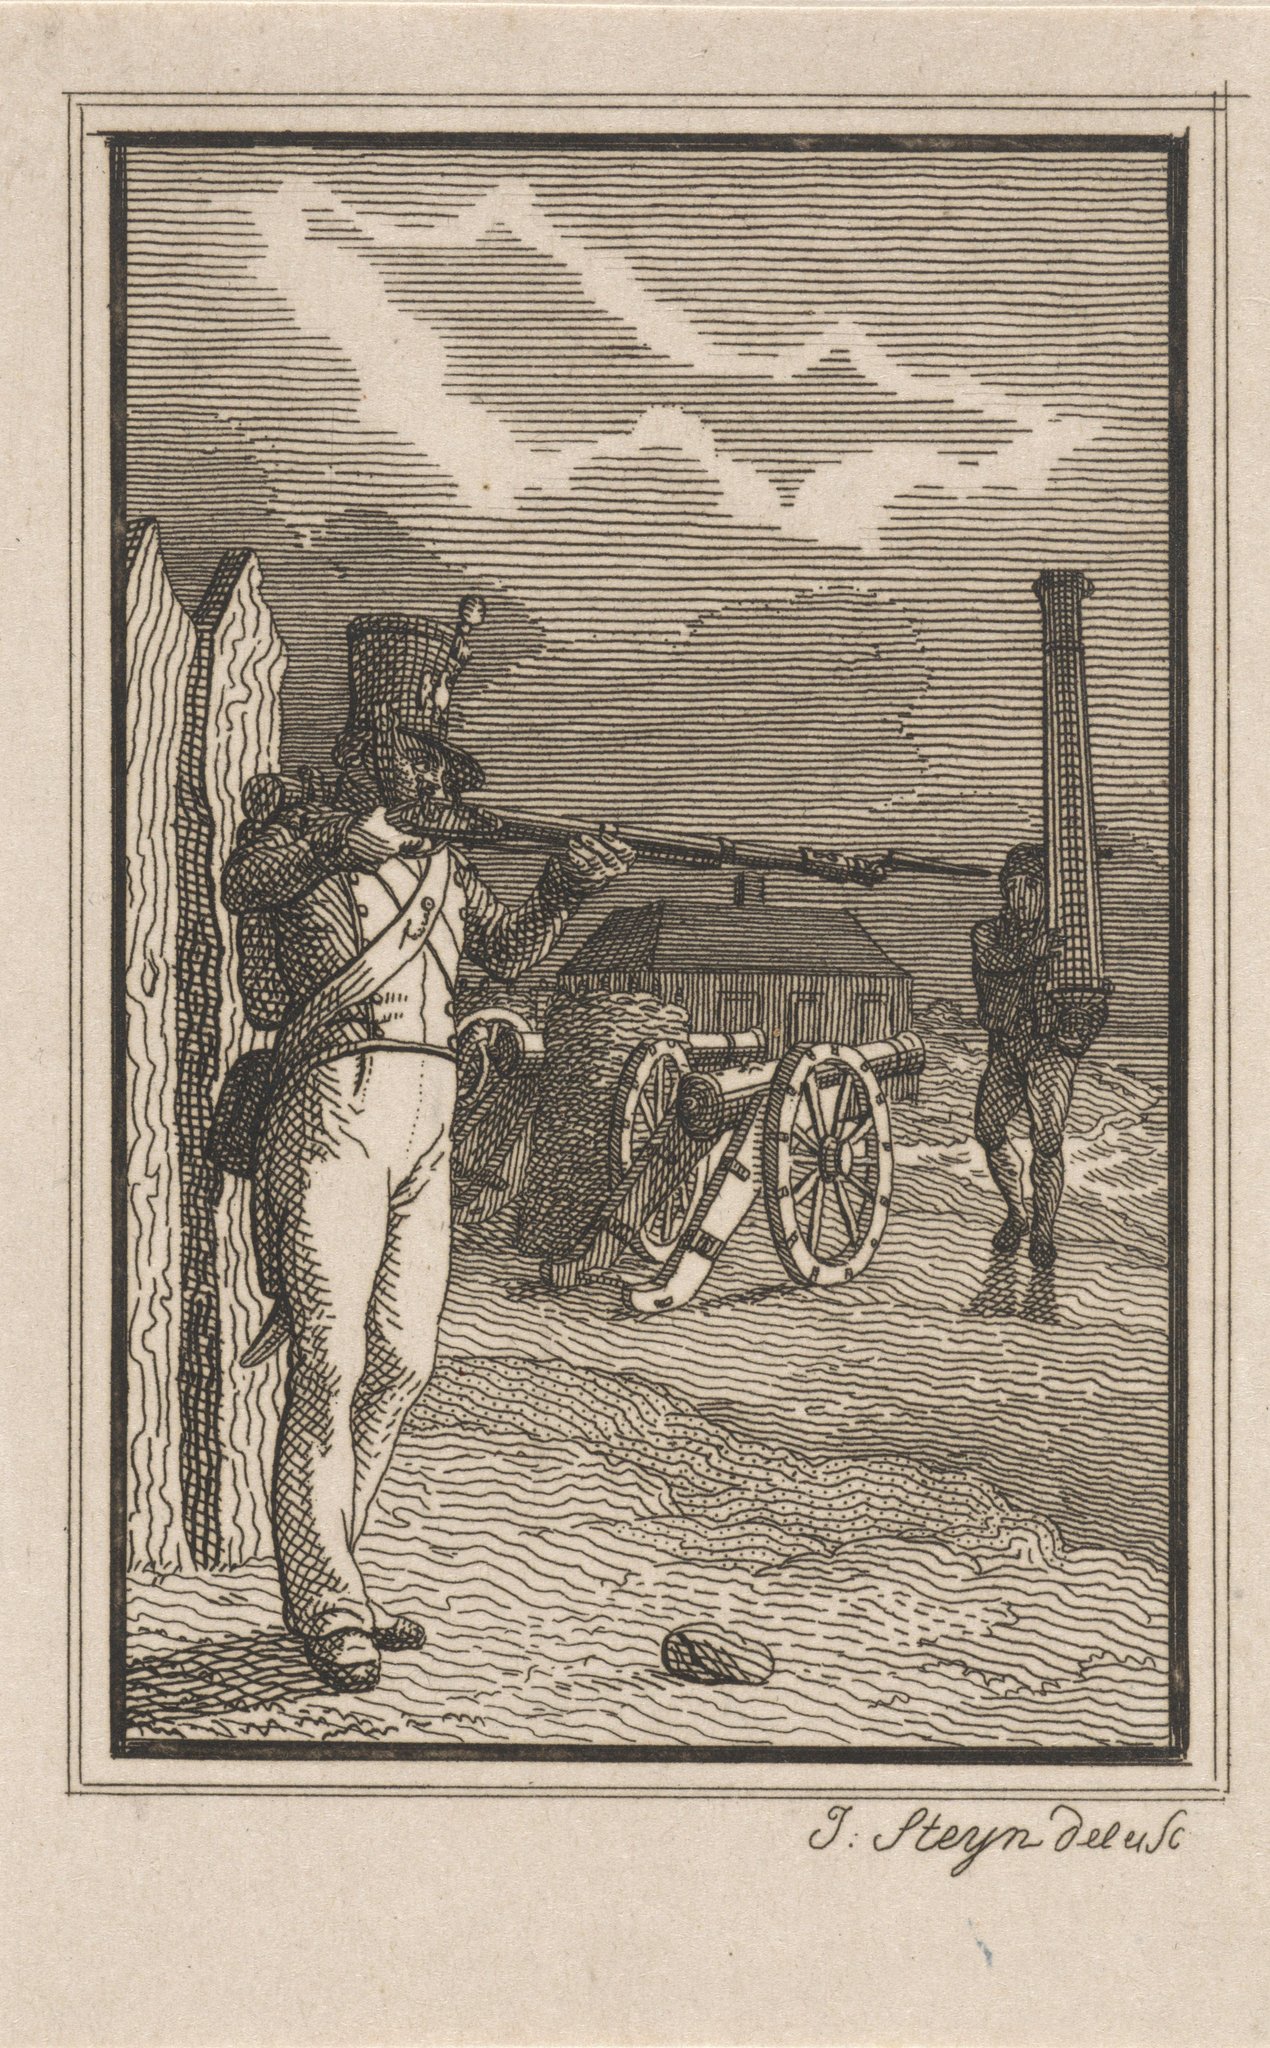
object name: print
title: Soldaat met geweer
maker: johannes steyn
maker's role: print maker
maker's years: 1805-1840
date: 1815-1840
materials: paper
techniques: etching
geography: amsterdam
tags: private soldier, firearms: cannon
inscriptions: collector's mark: Lugt 2228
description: Een soldaat legt zijn geweer aan. Op de achtergrond een man met de loop van een kanon in zijn armen.